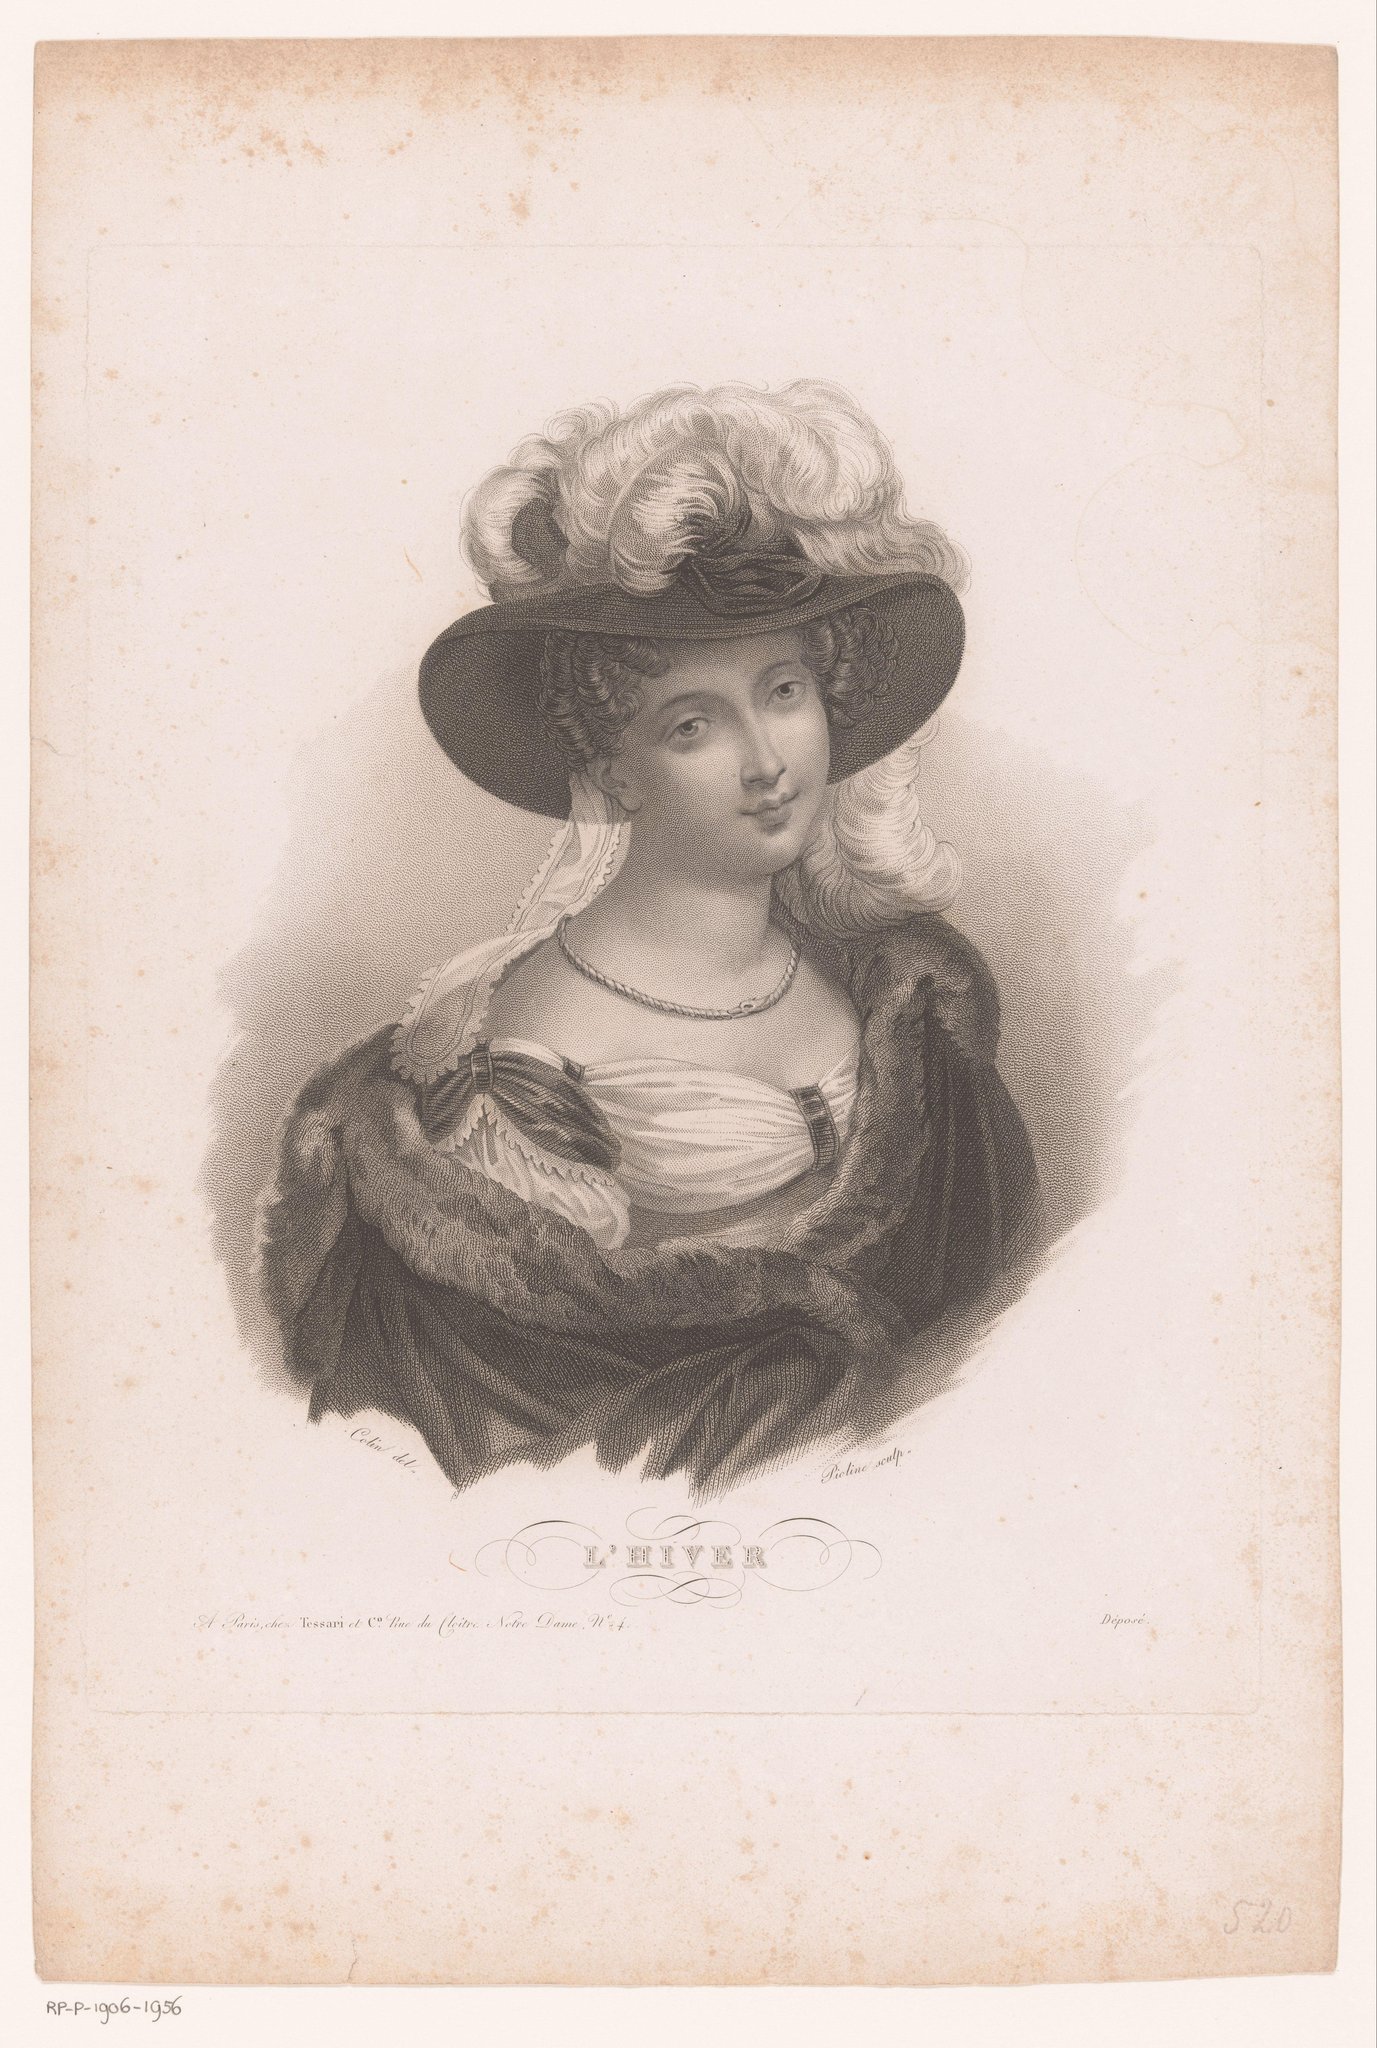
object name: print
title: Winter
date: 1820-1830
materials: paper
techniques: etching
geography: paris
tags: winter, 'hyems'; 'inverno' (ripa)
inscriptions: : ‘Déposé’, collector's mark: Lugt 2228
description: Vrouw met mantel en hoed als personificatie van de winter.